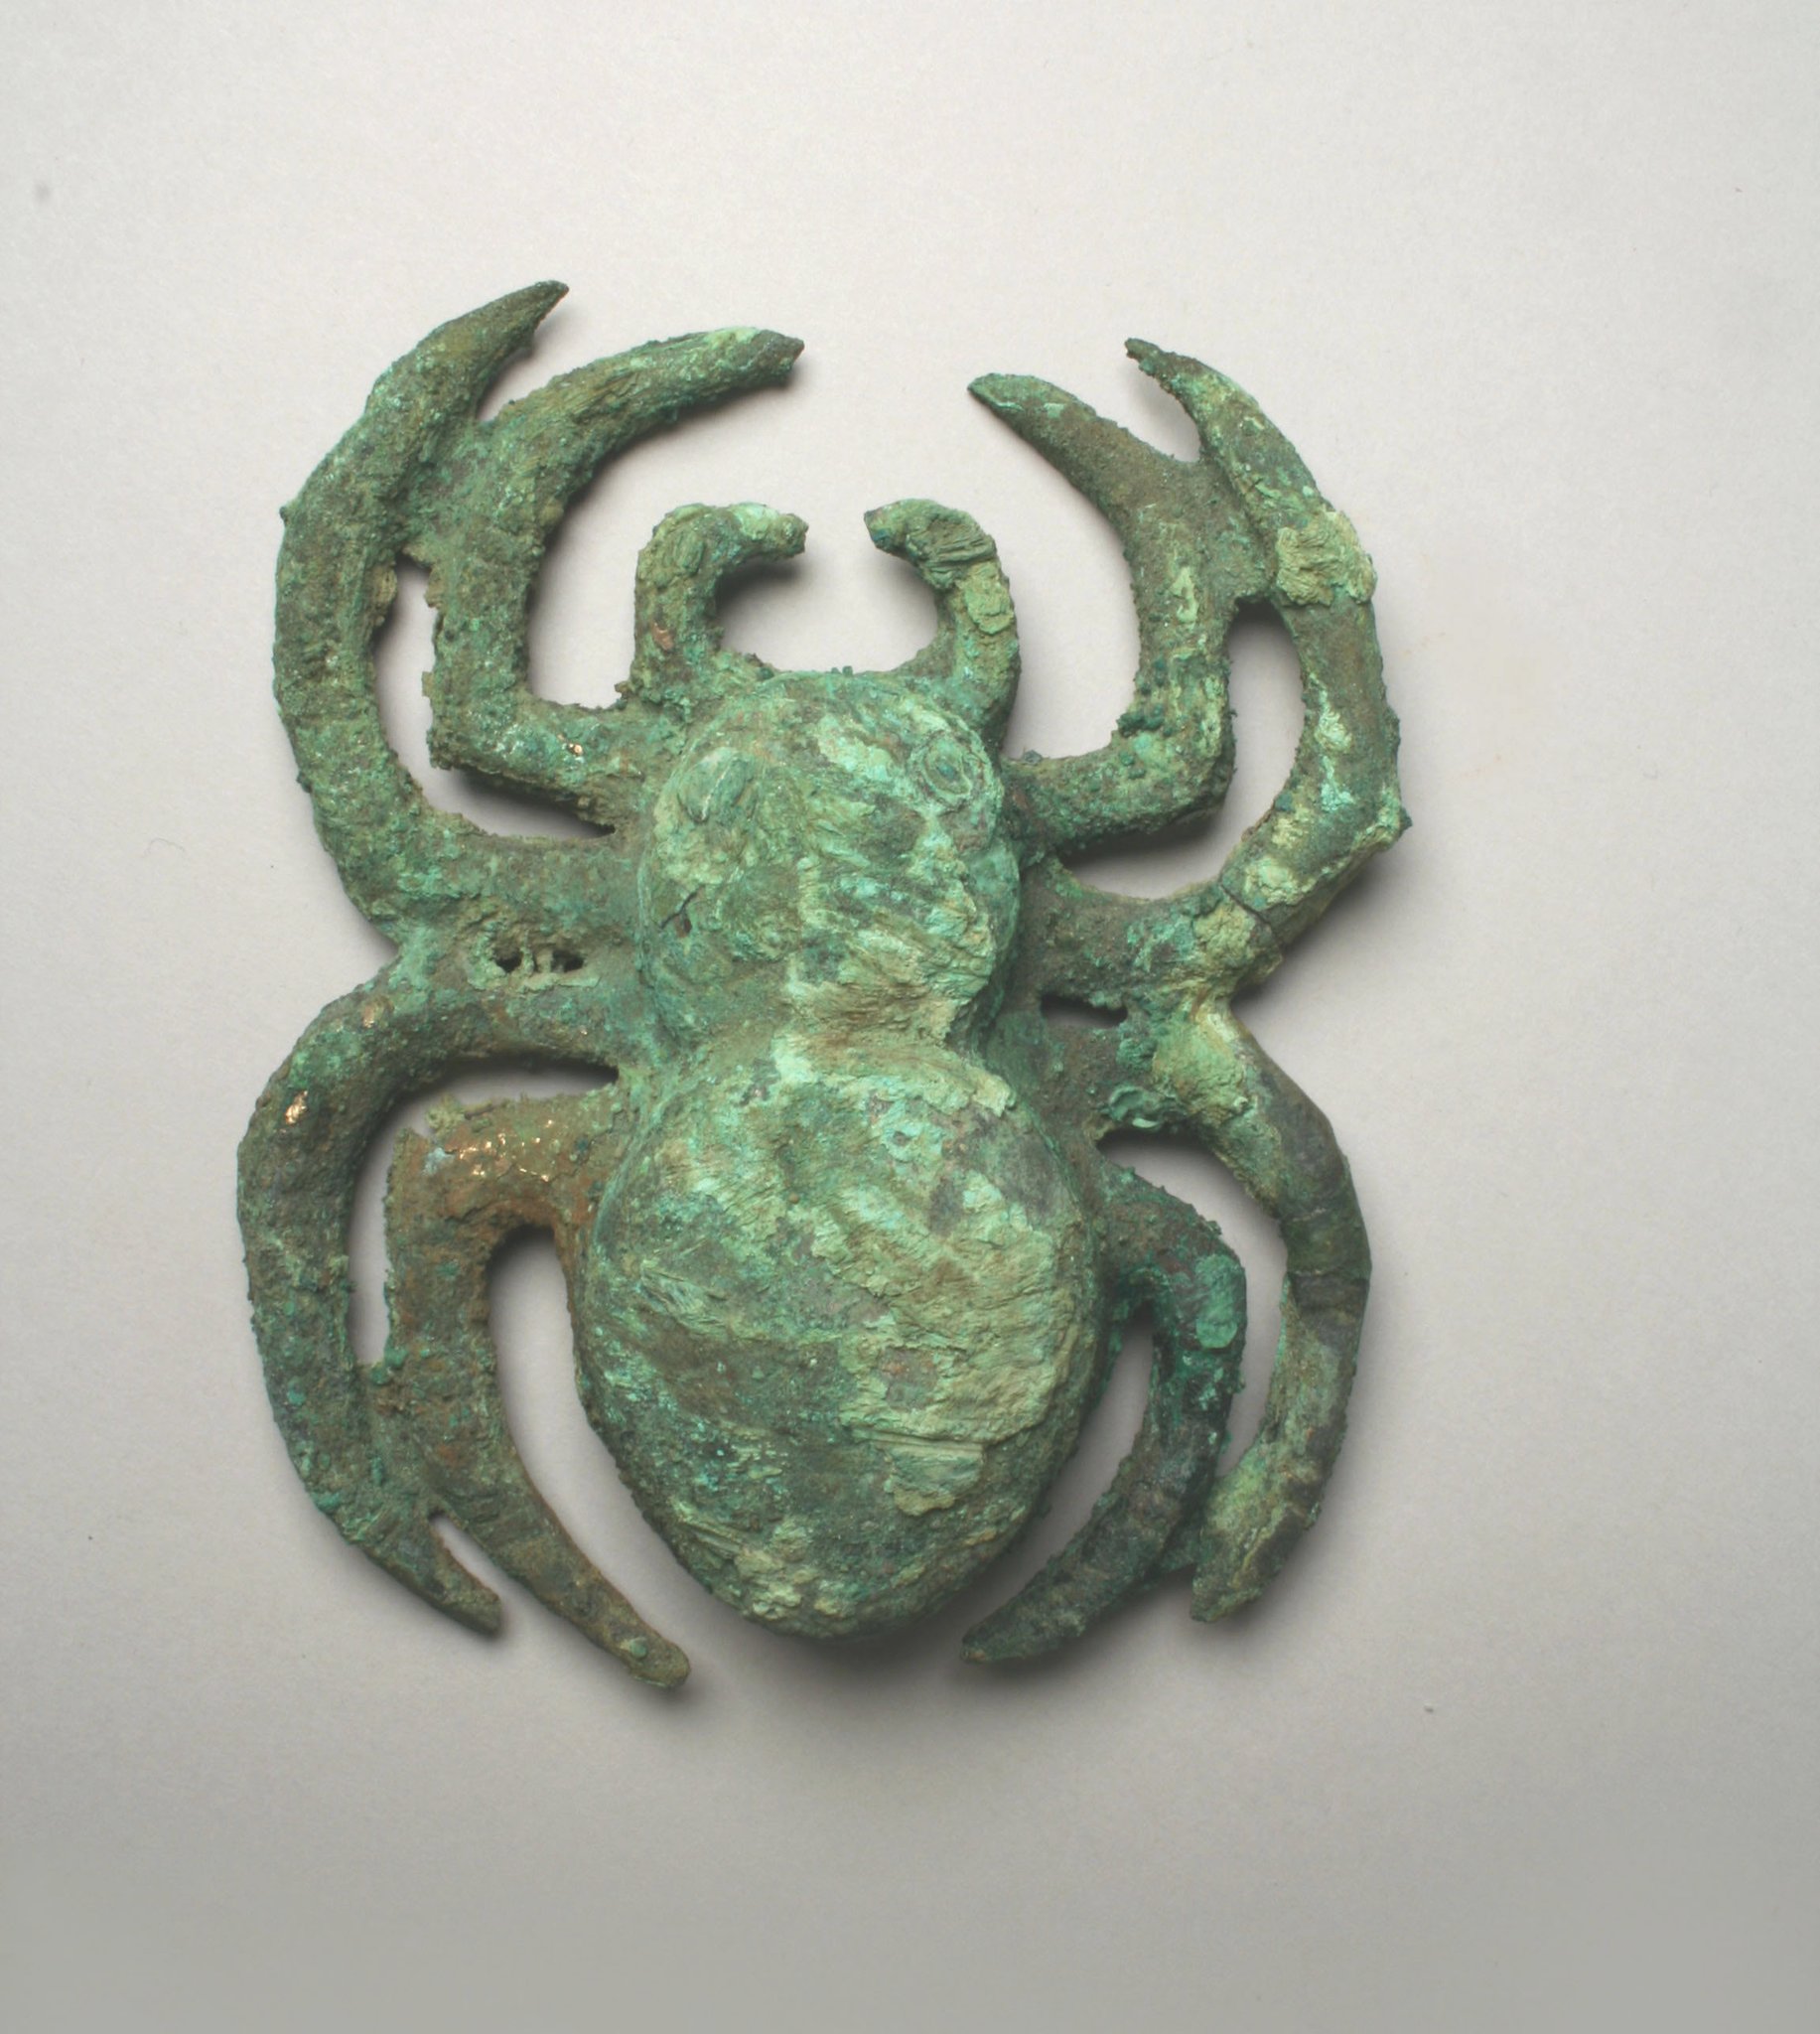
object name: ornament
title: Spider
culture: moche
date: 501-700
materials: gilt copper, shell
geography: peru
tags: animals